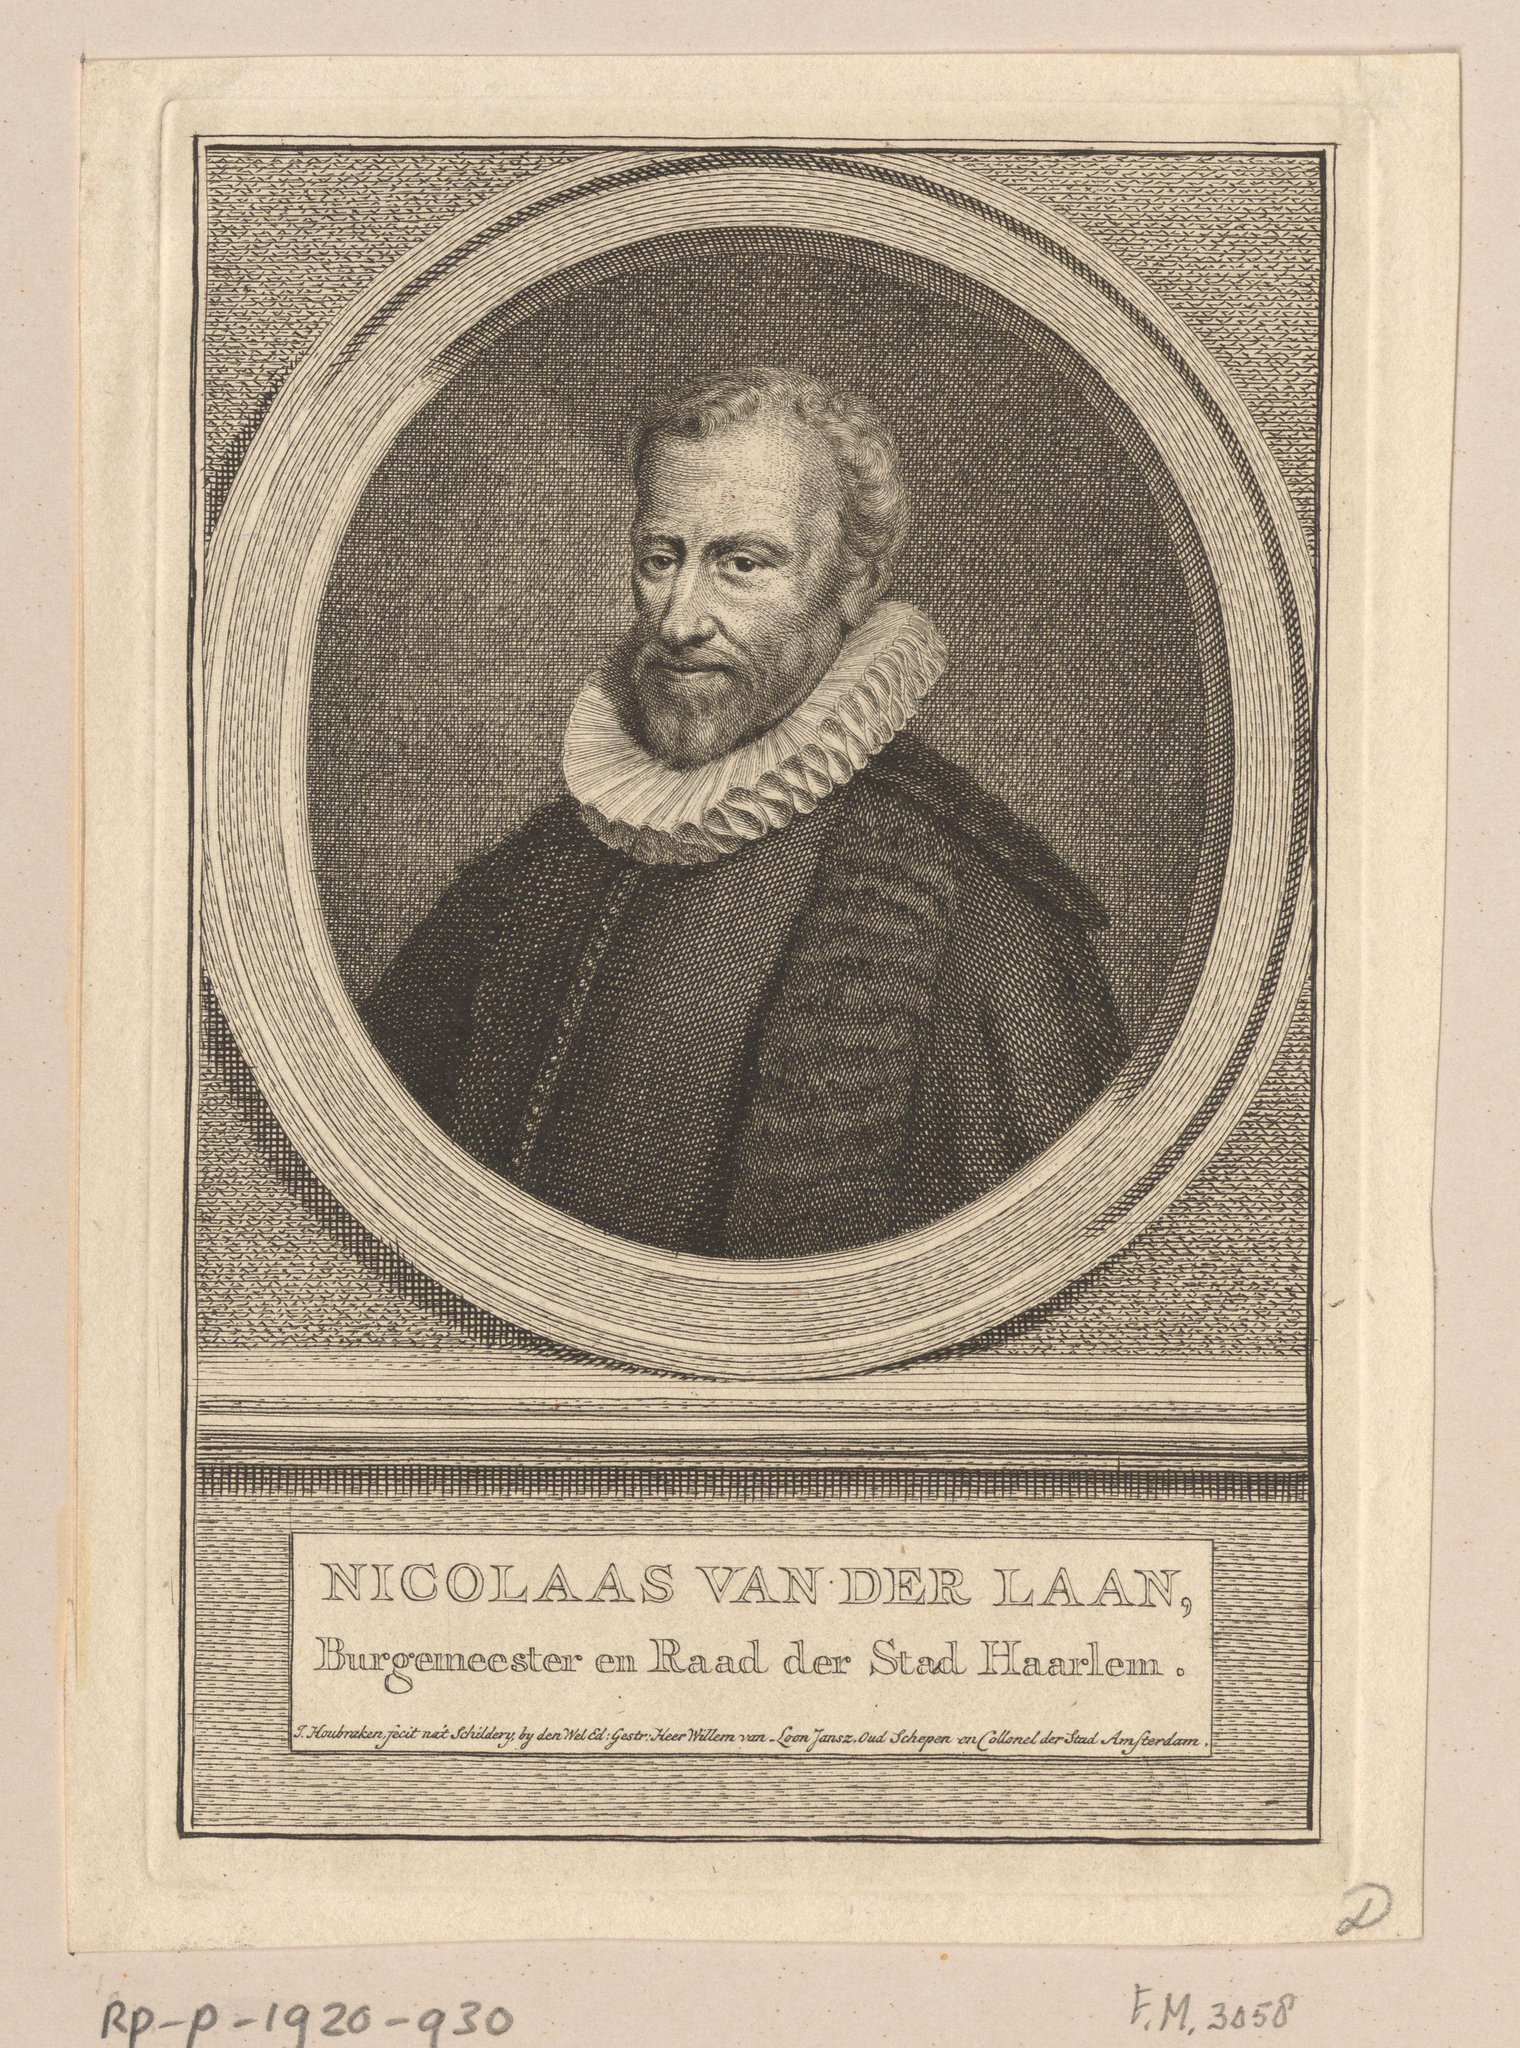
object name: print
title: Portret van Nikolaas van der Laan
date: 1749-1796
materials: paper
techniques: engraving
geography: amsterdam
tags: mayor, burgomaster, historical persons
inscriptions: collector's mark: Lugt 2228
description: Prent komt waarschijnlijk uit een editie van Jan Wagenaars 'Vaderlandsche historie', vanaf 1749 in verschillende delen en drukken verschenen tot 1796. De prent is postuum uitgegeven door Johannes Allart.